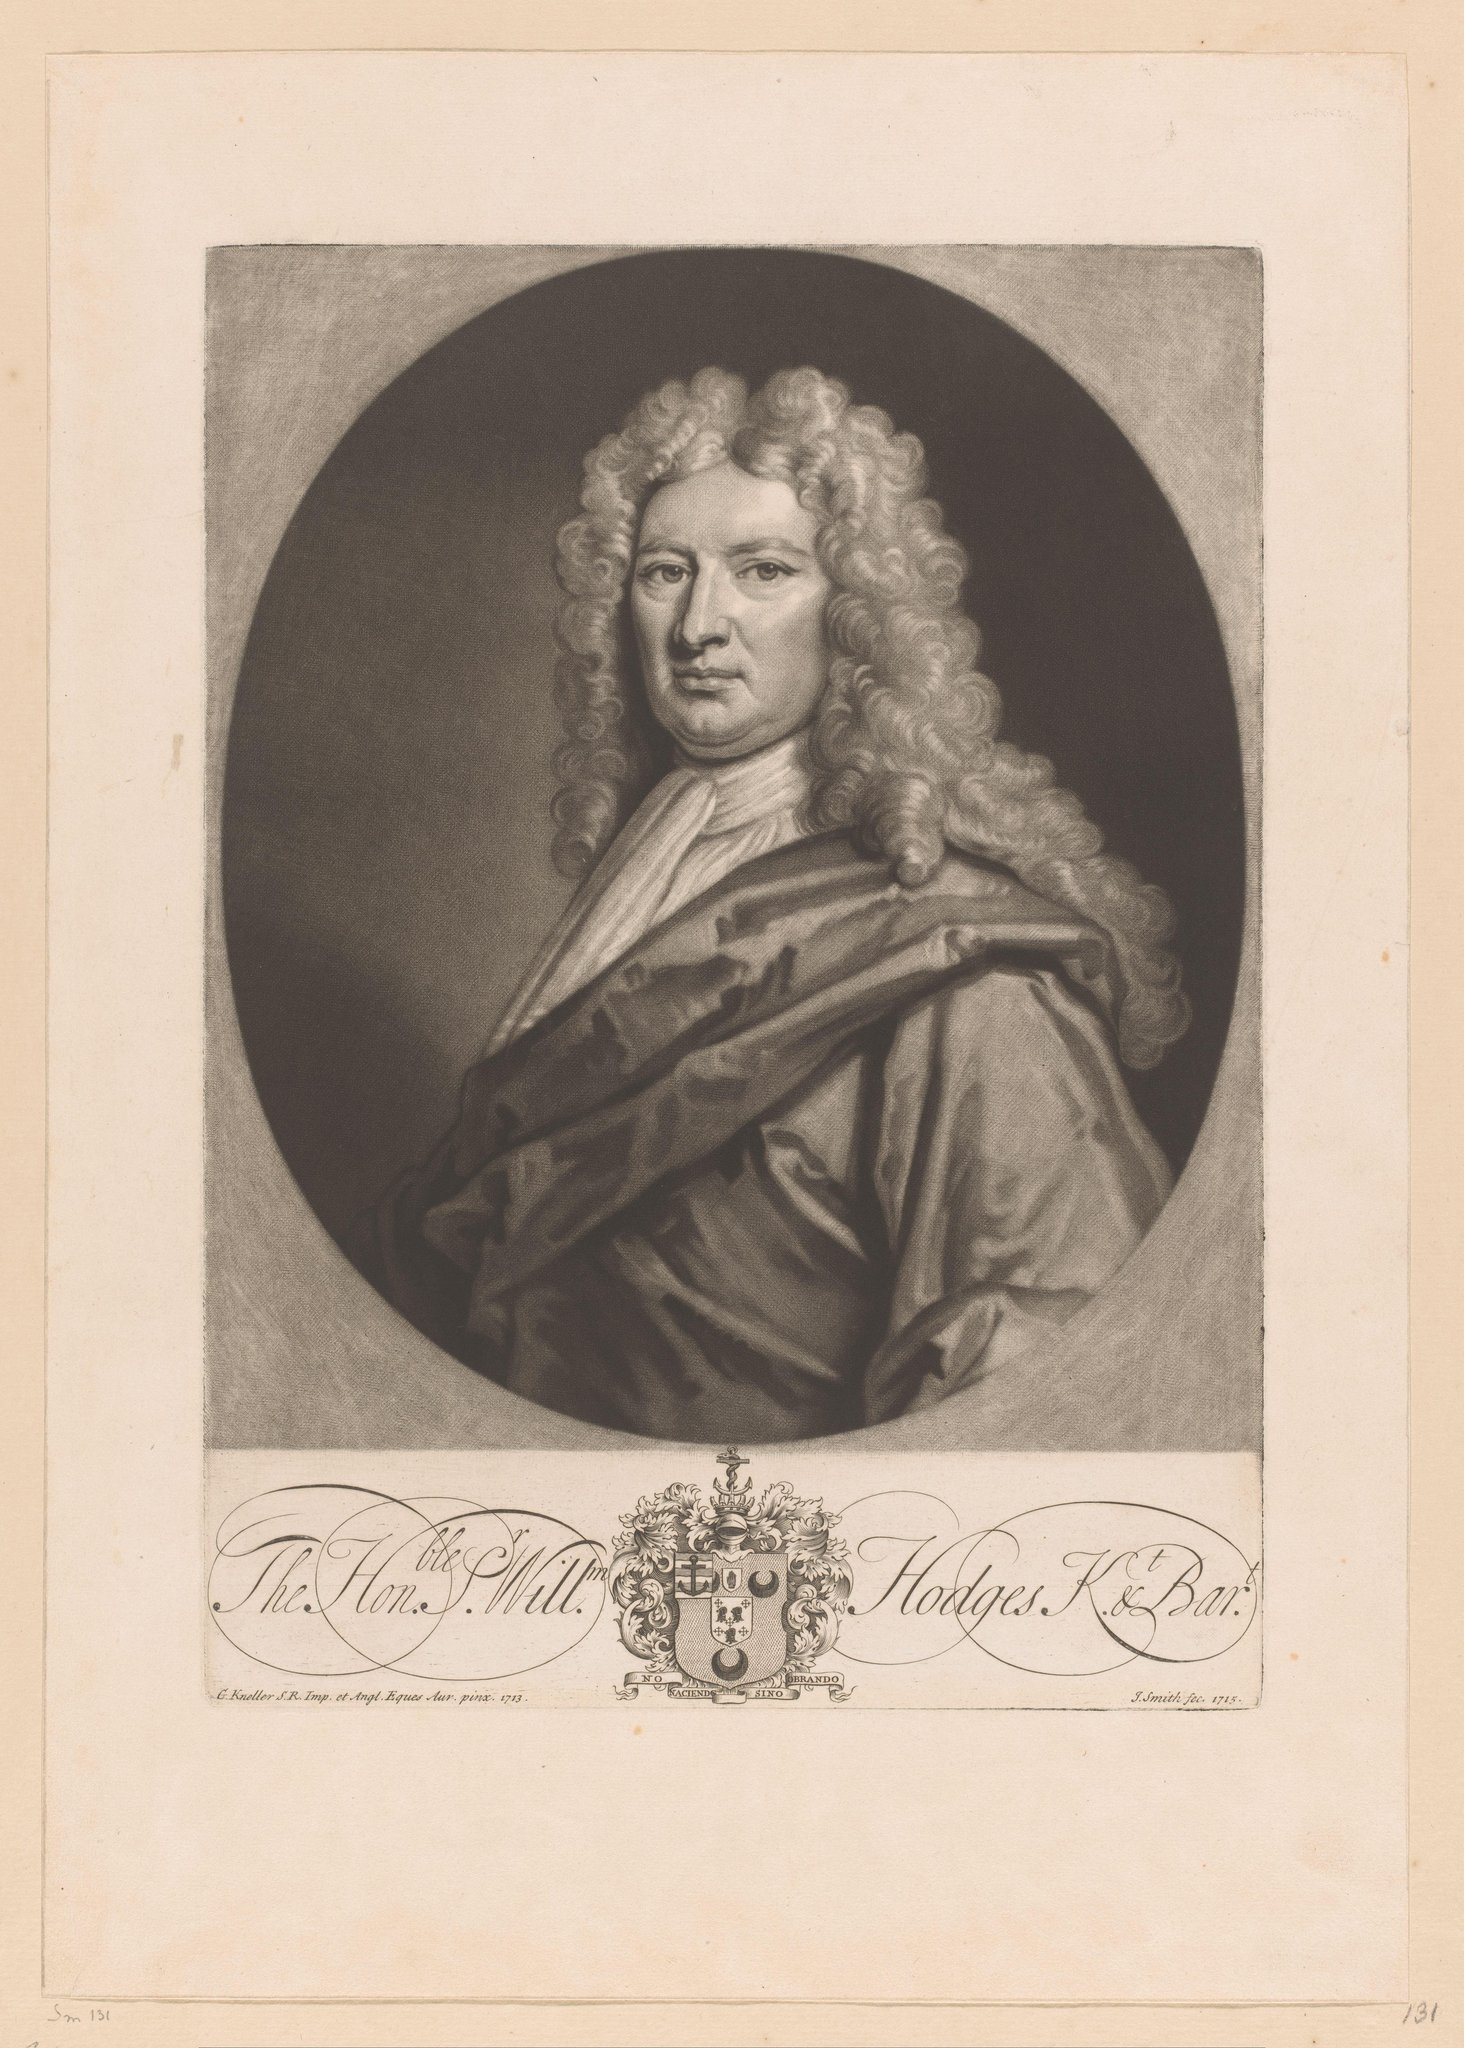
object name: print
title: Portret van William Hodges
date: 1713-1715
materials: paper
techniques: mezzotint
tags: politician, historical persons, politician, e.g. party leader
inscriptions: collector's mark: Lugt 240